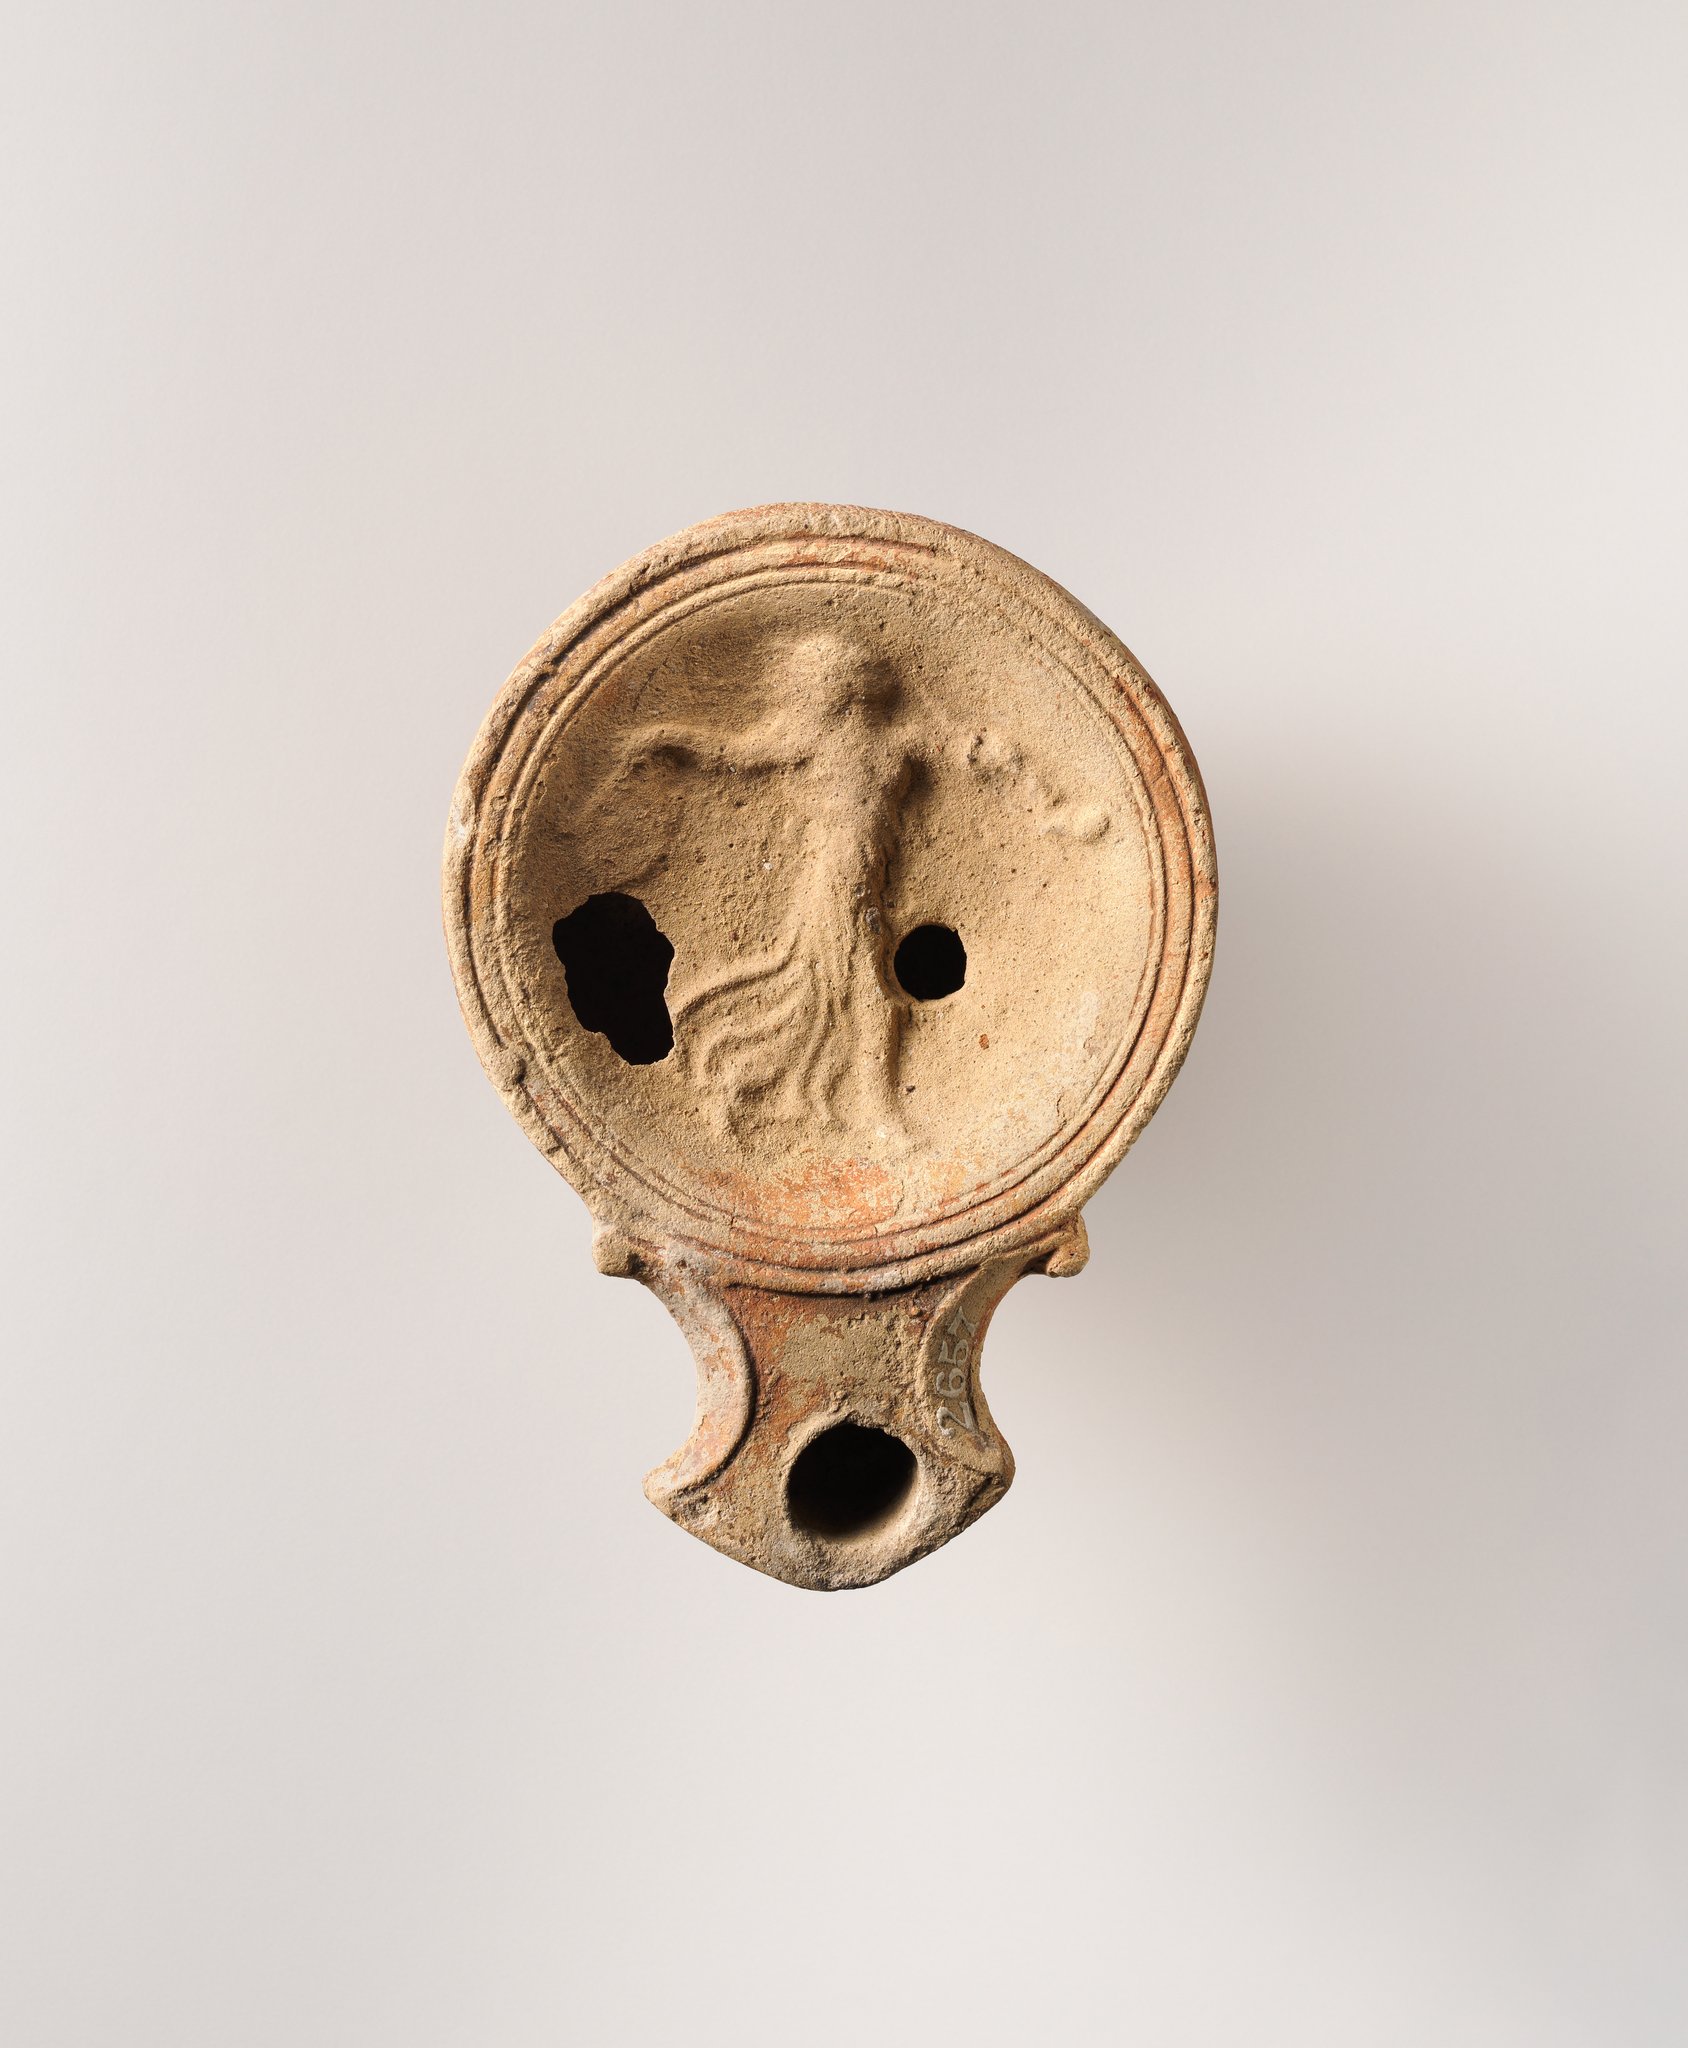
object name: lamp, concave top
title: Terracotta oil lamp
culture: roman, cypriot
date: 100 BCE-100 CE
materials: terracotta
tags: maenads